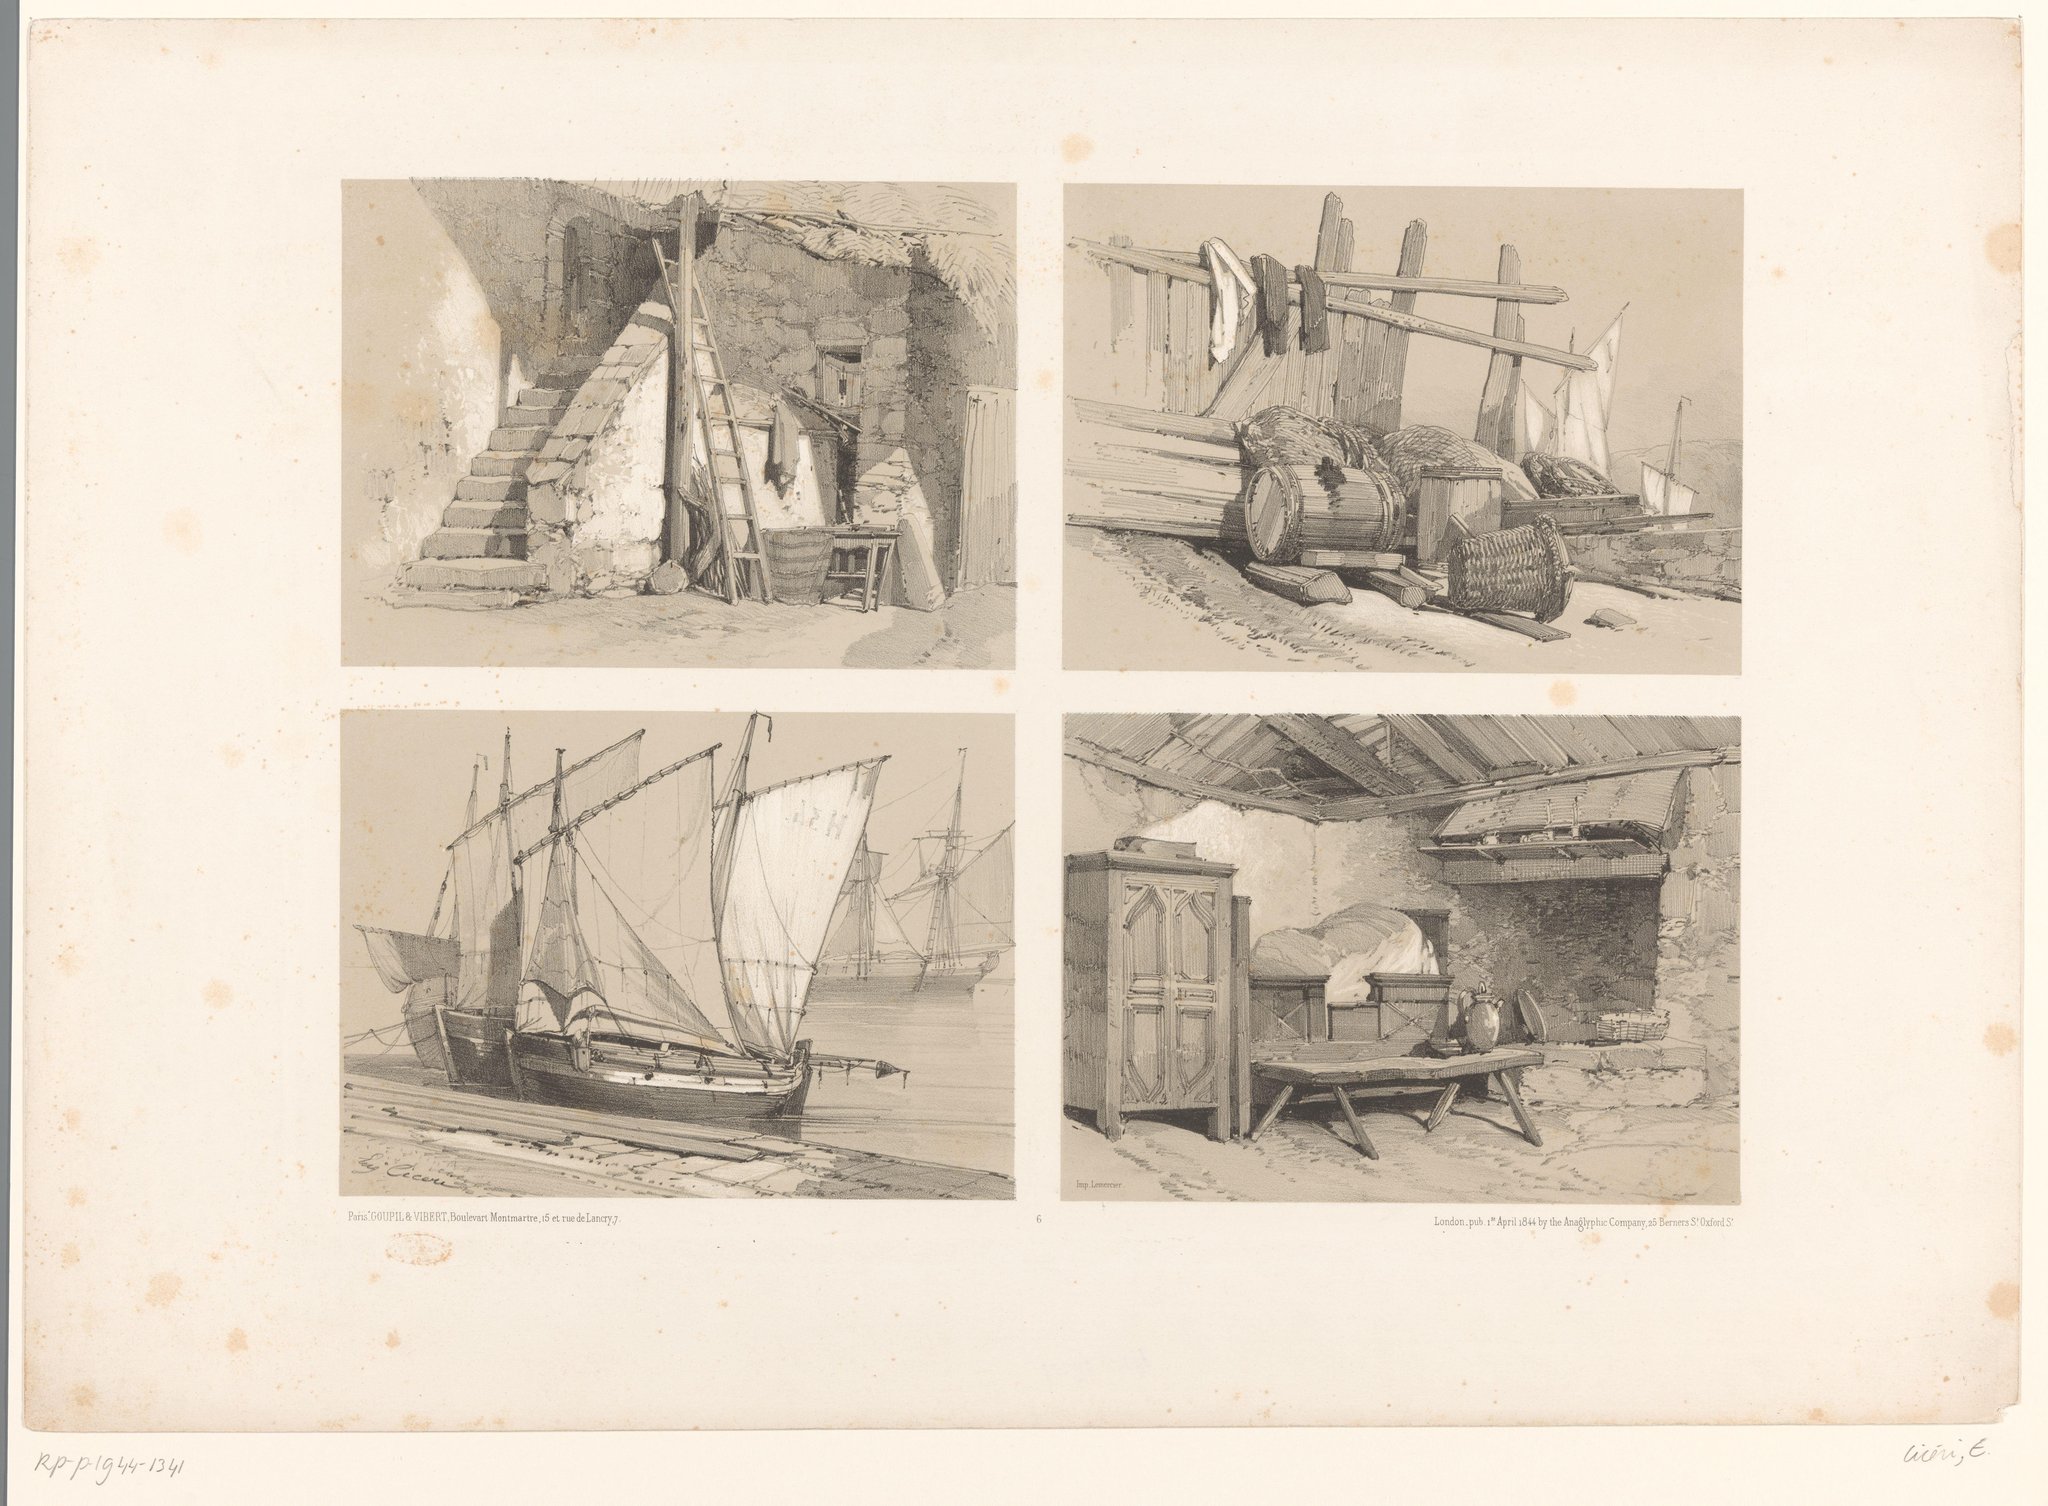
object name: print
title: Manden en vaten aan de kade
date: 1835-1890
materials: paper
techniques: tone lithography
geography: london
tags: wooden container: barrel, cask, bucket, courtyard, bedroom, sea and coastal fishery, pier, quay, wharf (+ view ~ vehicle, ship, etc.)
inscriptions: collector's mark: Lugt 2228a, check stamp: Lugt 5003